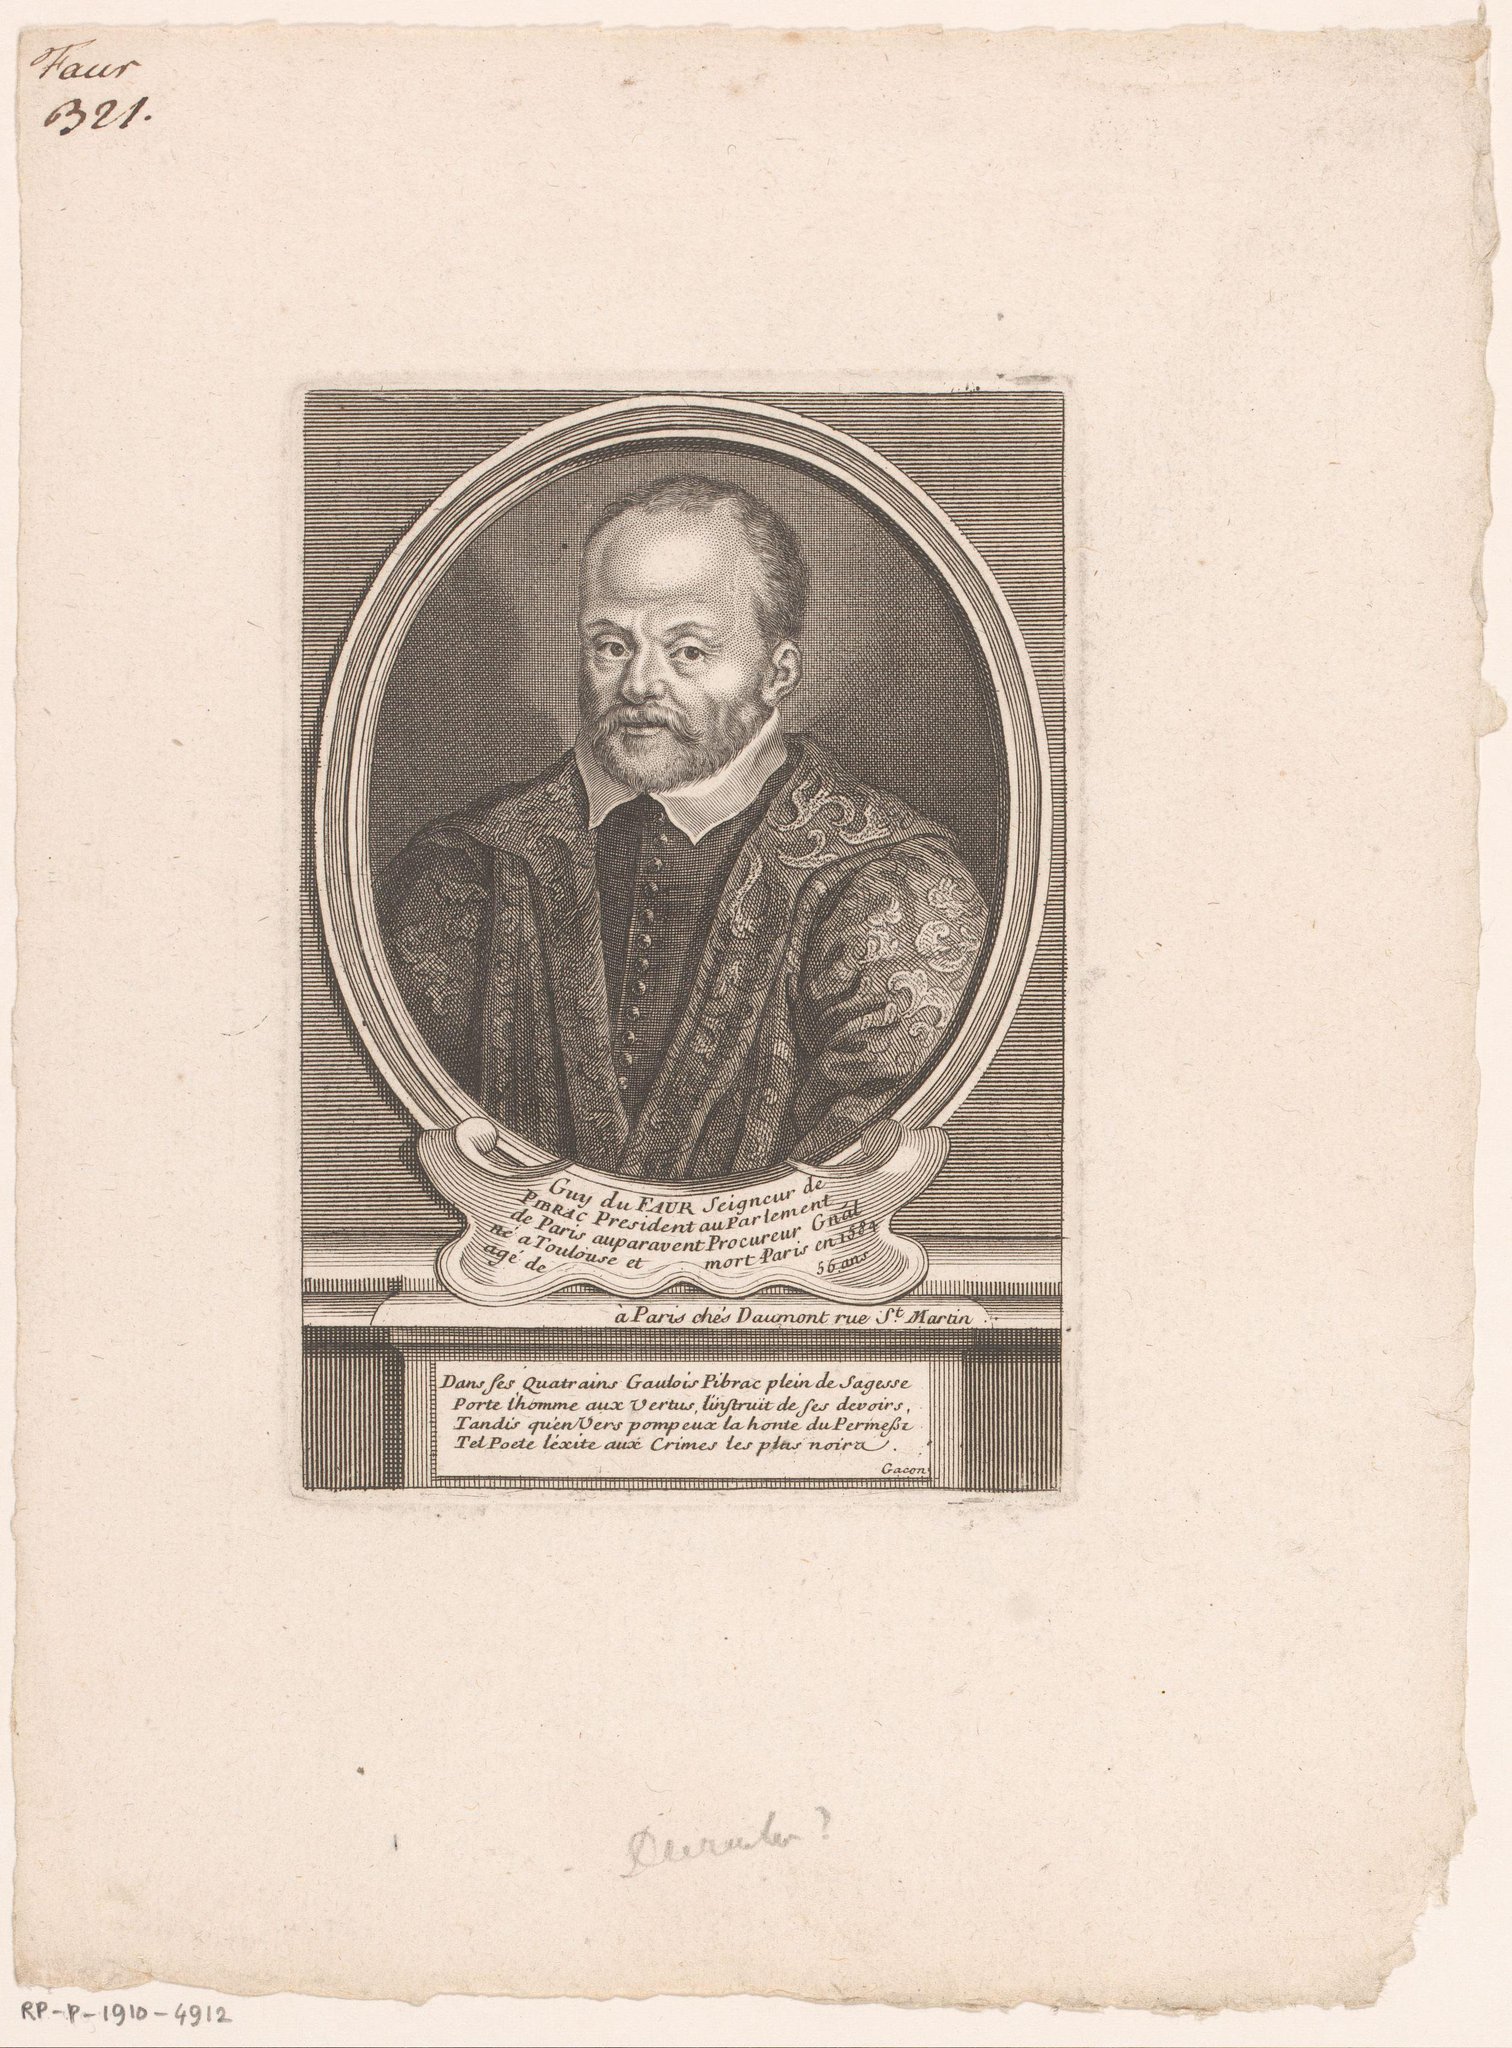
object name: print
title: Verzameling portretten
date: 1726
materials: paper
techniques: engraving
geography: paris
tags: paris, historical persons, portrait of a writer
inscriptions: collector's mark: Lugt 2228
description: Behoort waarschijnlijk tot een serie portretten, grotendeels door Etienne Desrochers, getiteld: 'Recueil de portraits de personnes qui se sont distinguées tant dans les Armes que dans Belles-Lettres et les Arts, comme aussi la famille royale de France et autres cours étrangères'. De serie werd initieel uitgegeven door Desrochers en aangekondigd in 'Mercure' in mei 1726, p. 985. Echter was Desrochers reeds enkele jaren eerder begonnen met het uitgeven van de serie. Na de dood van Desrochers werd de serie voortgezet door Gilles Edme Petit. Een latere staat werd uitgegeven door Jean François Daumont in Parijs.